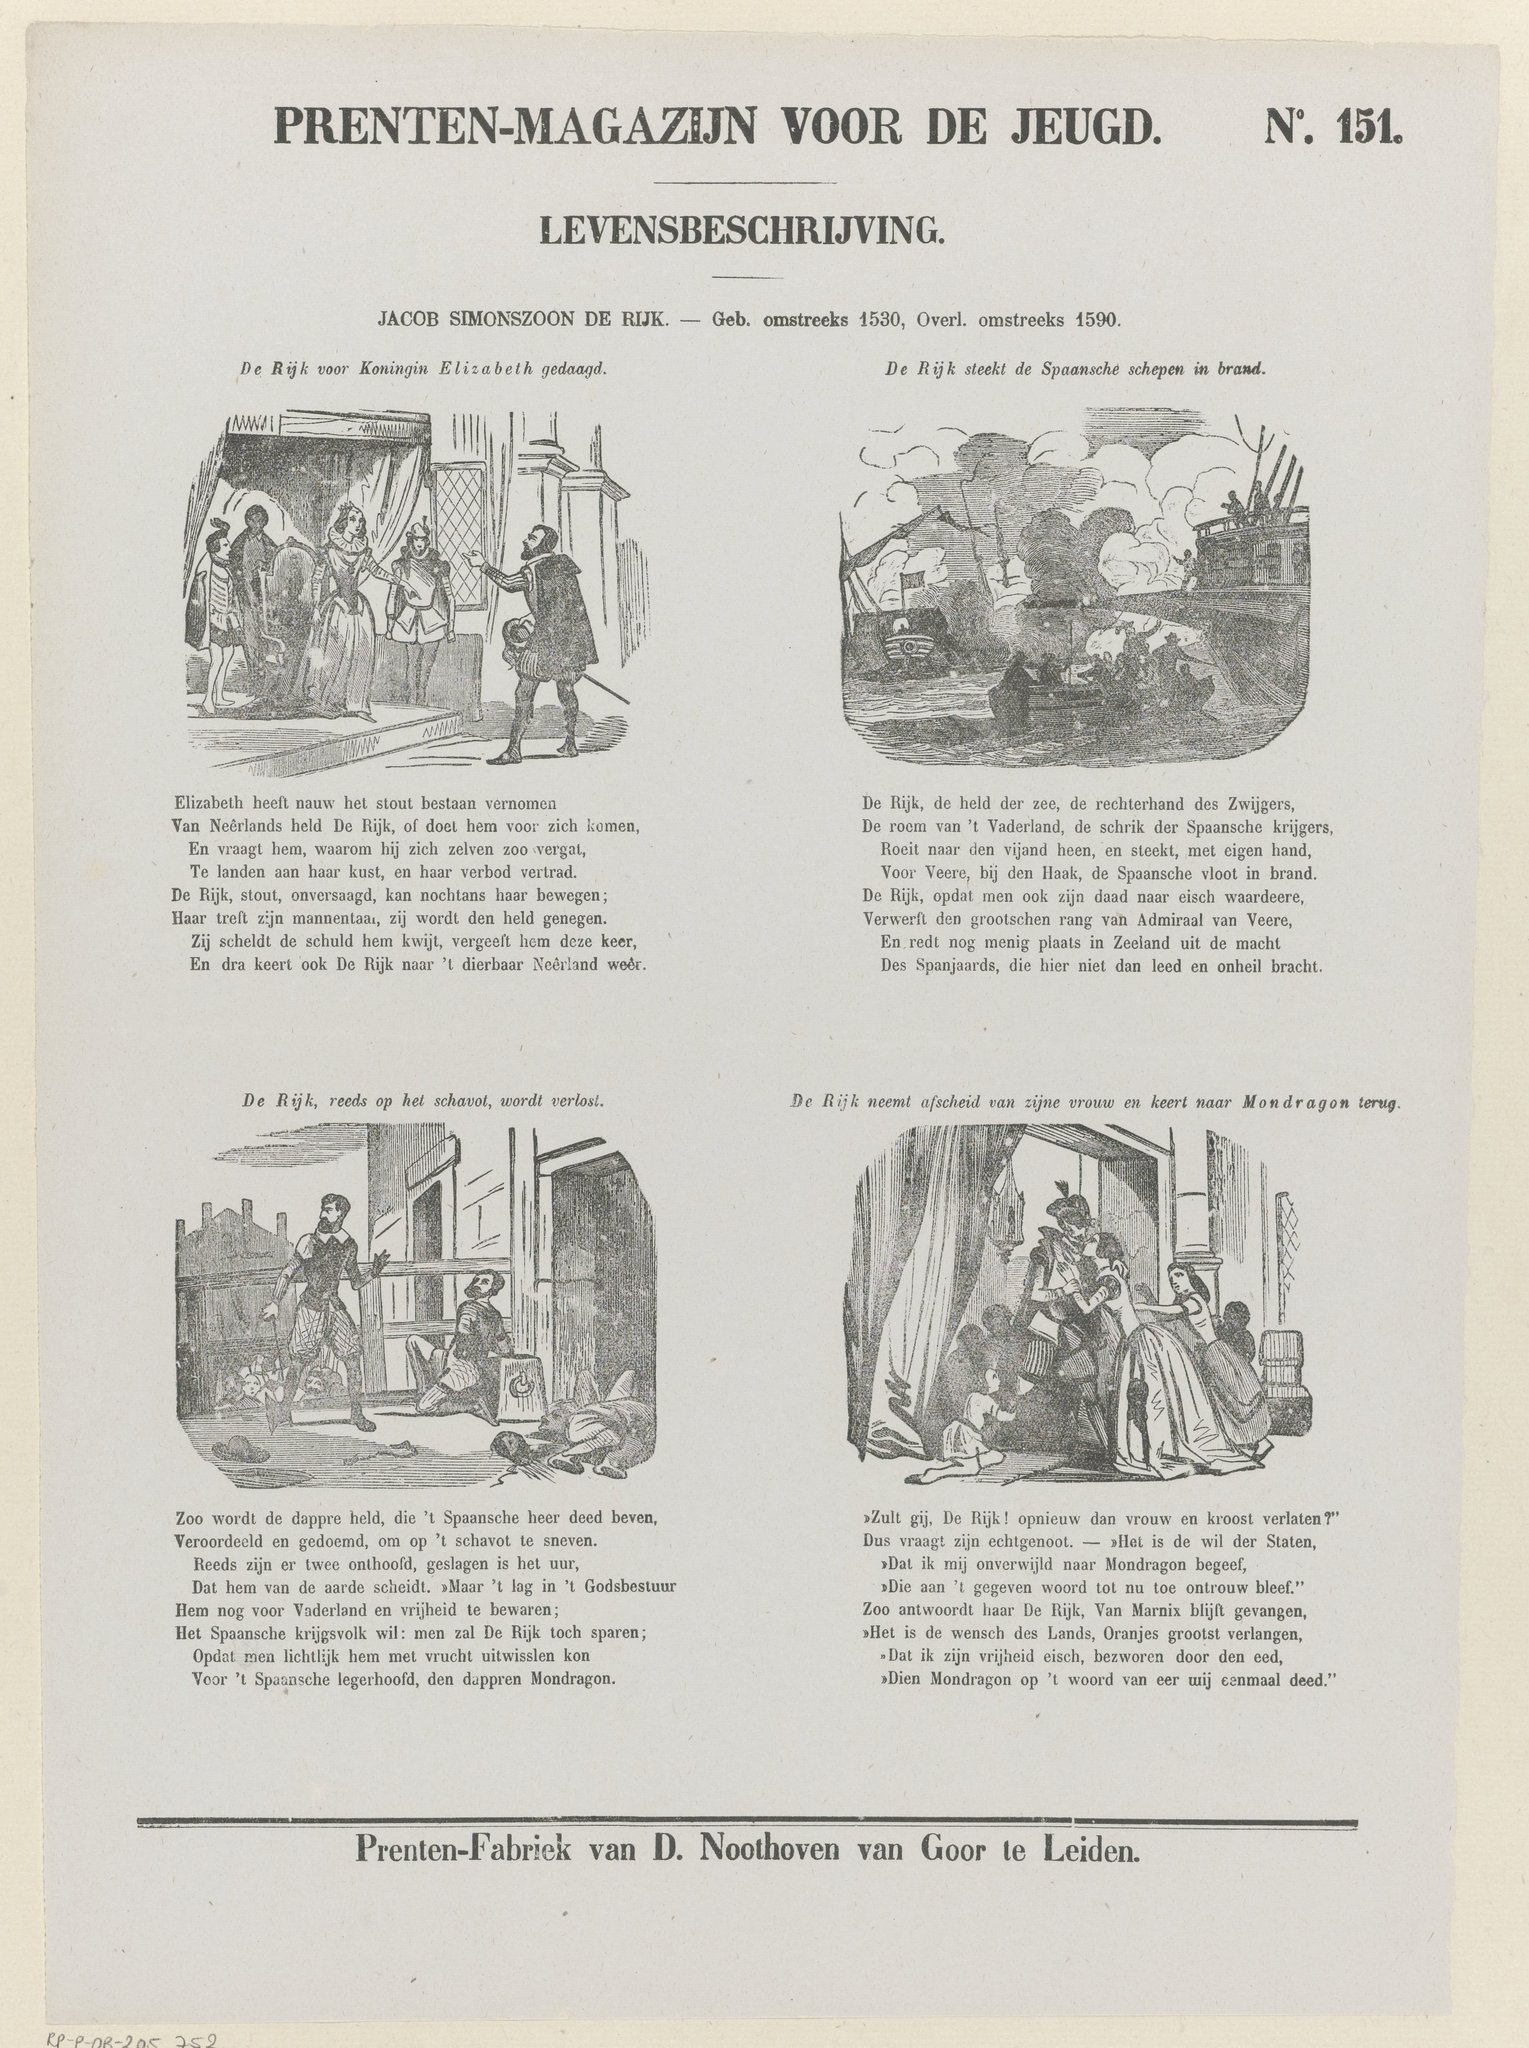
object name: print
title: Prenten-magazijn voor de jeugd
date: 1850-1881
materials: paper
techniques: letterpress printing, engraving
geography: leiden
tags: historical persons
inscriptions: collector's mark: Lugt 2760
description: Blad met 4 voorstellingen uit het leven van Jacob Simons de Rijk. Boven elke voorstelling een titel en onder elke voorstelling een achtregelig vers. Genummerd rechtsboven: No. 151.